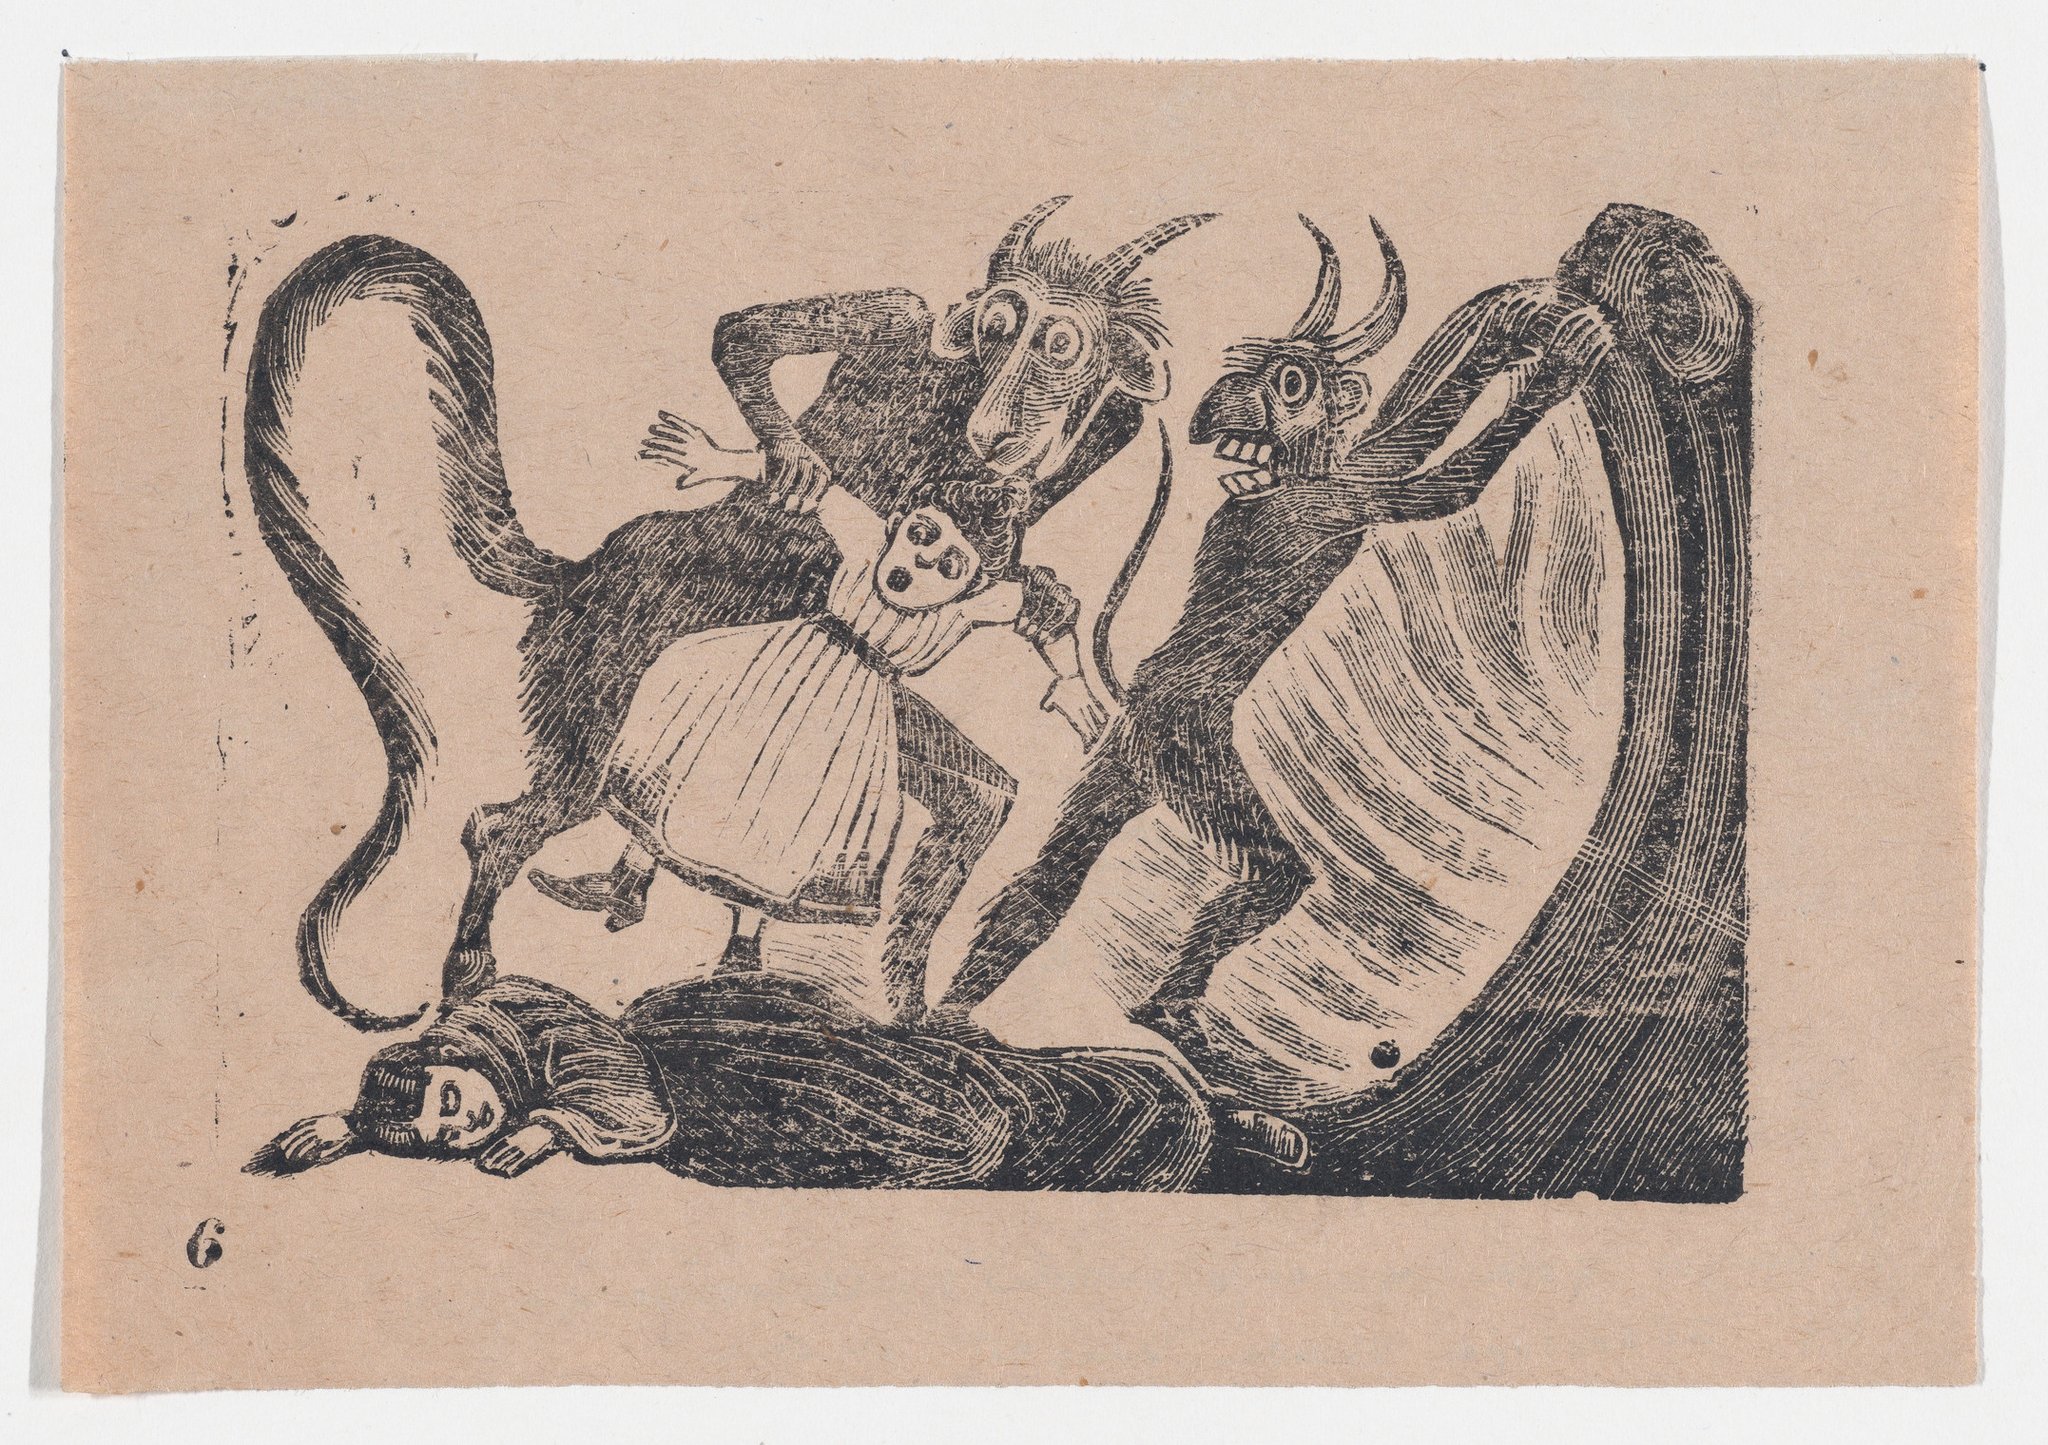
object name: print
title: Plate 6: Terrible fate of a young woman who after a calumny was snatched by the devil and dragged to hell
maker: josé guadalupe posada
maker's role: artist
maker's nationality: mexican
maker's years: 1852-1913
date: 1896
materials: metal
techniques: engraving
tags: girls,women